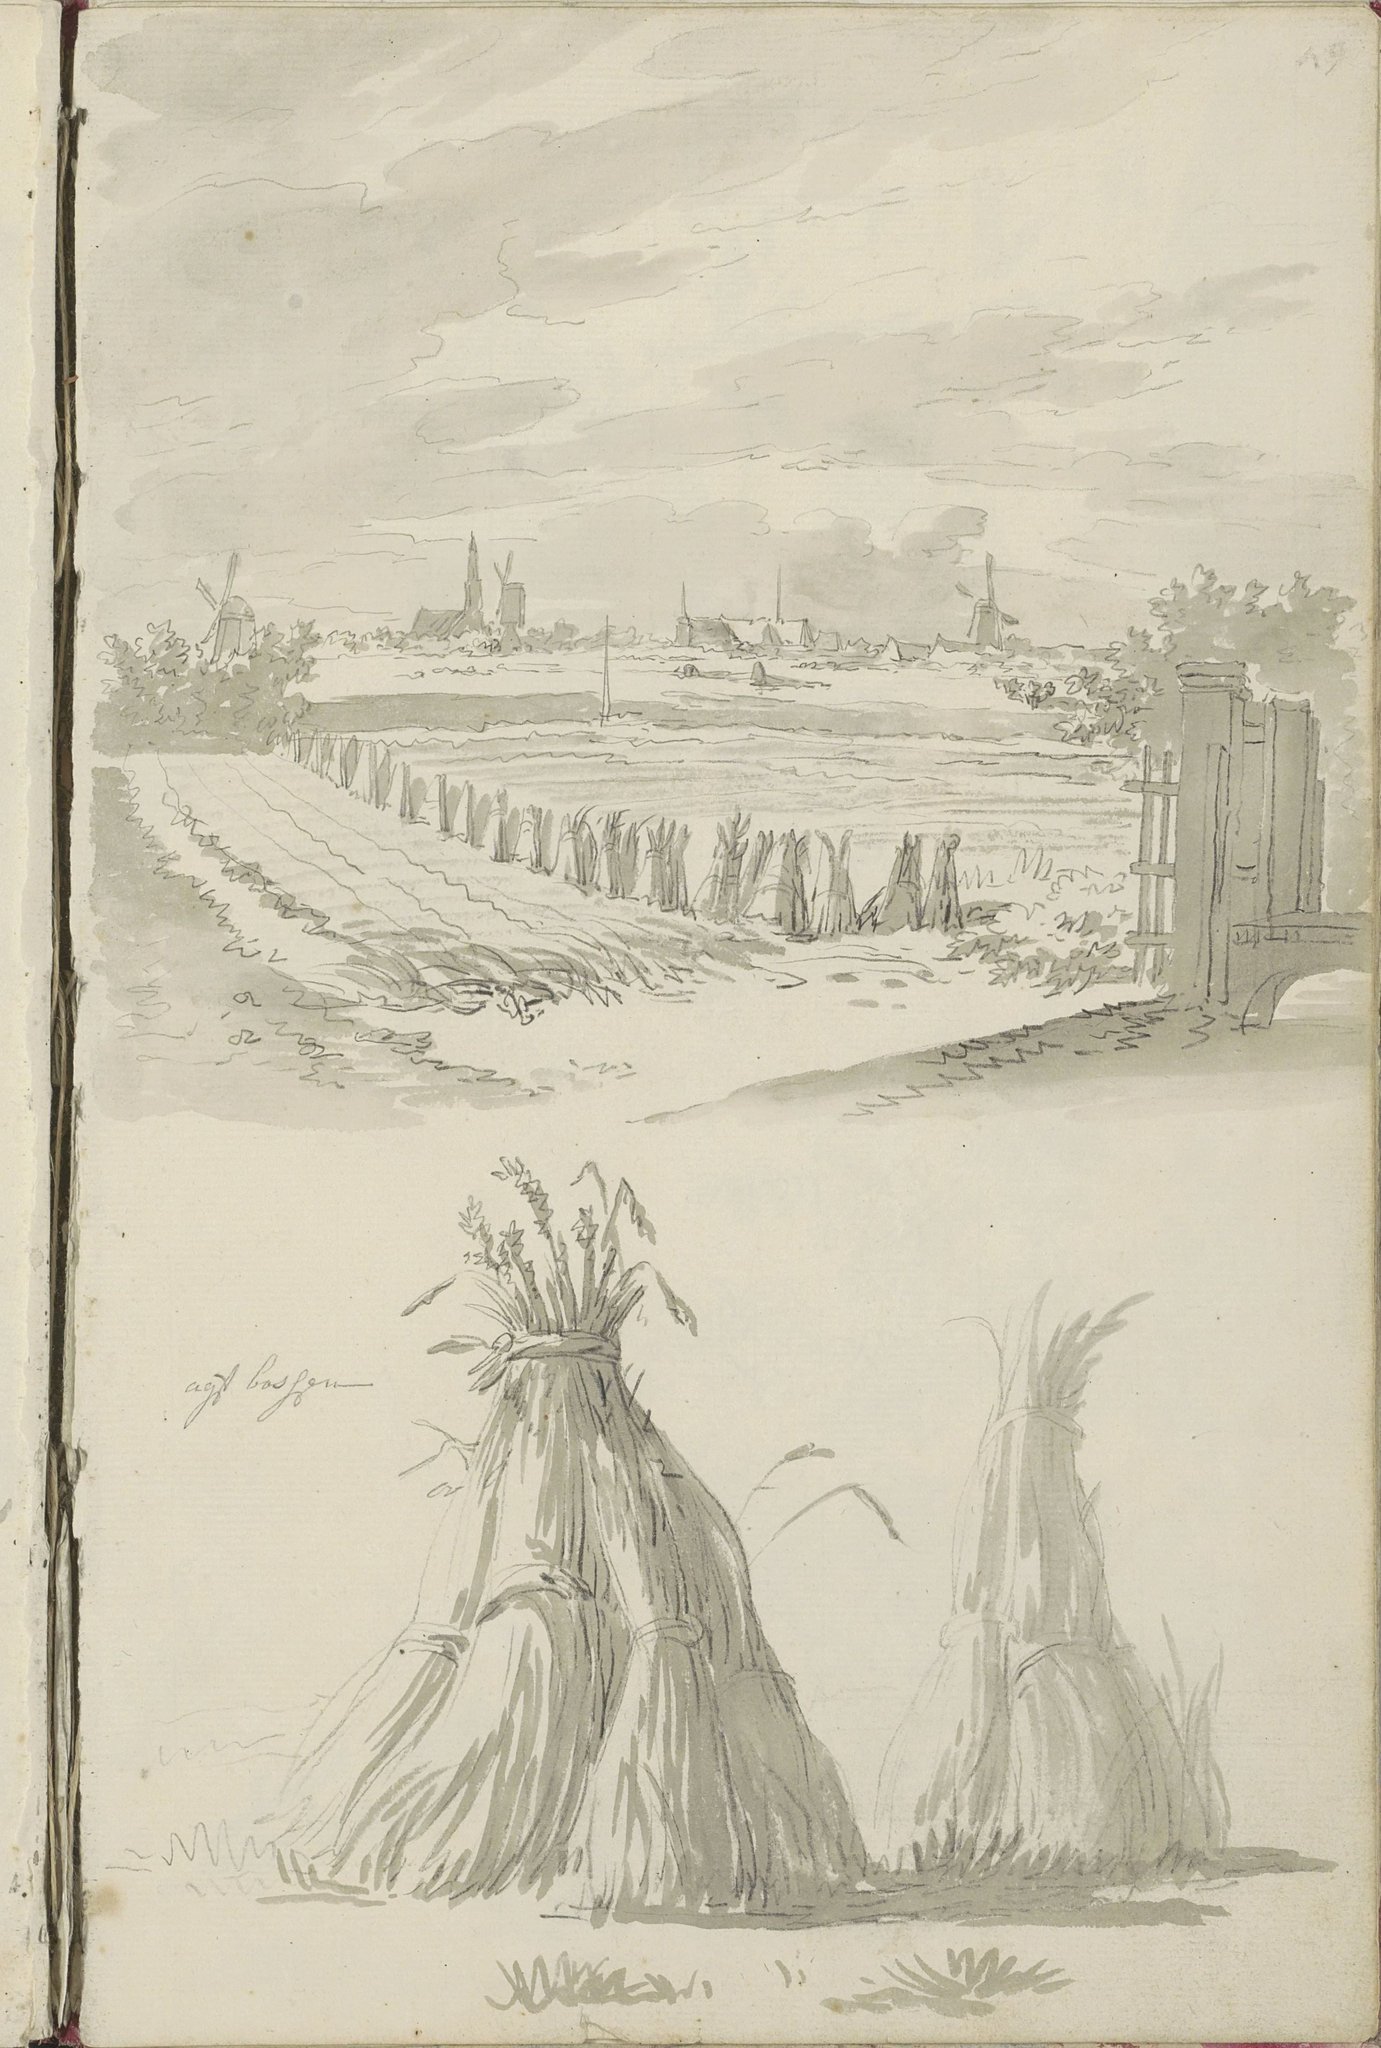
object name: sketchbook leaf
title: Landschap met korenschoven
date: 1780-1800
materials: paper, pencil, watercolor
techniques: brush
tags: landscapes, sheaf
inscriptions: annotation: ‘agt bossen’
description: Blad 6 verso uit een schetsboek met 25 bladen.